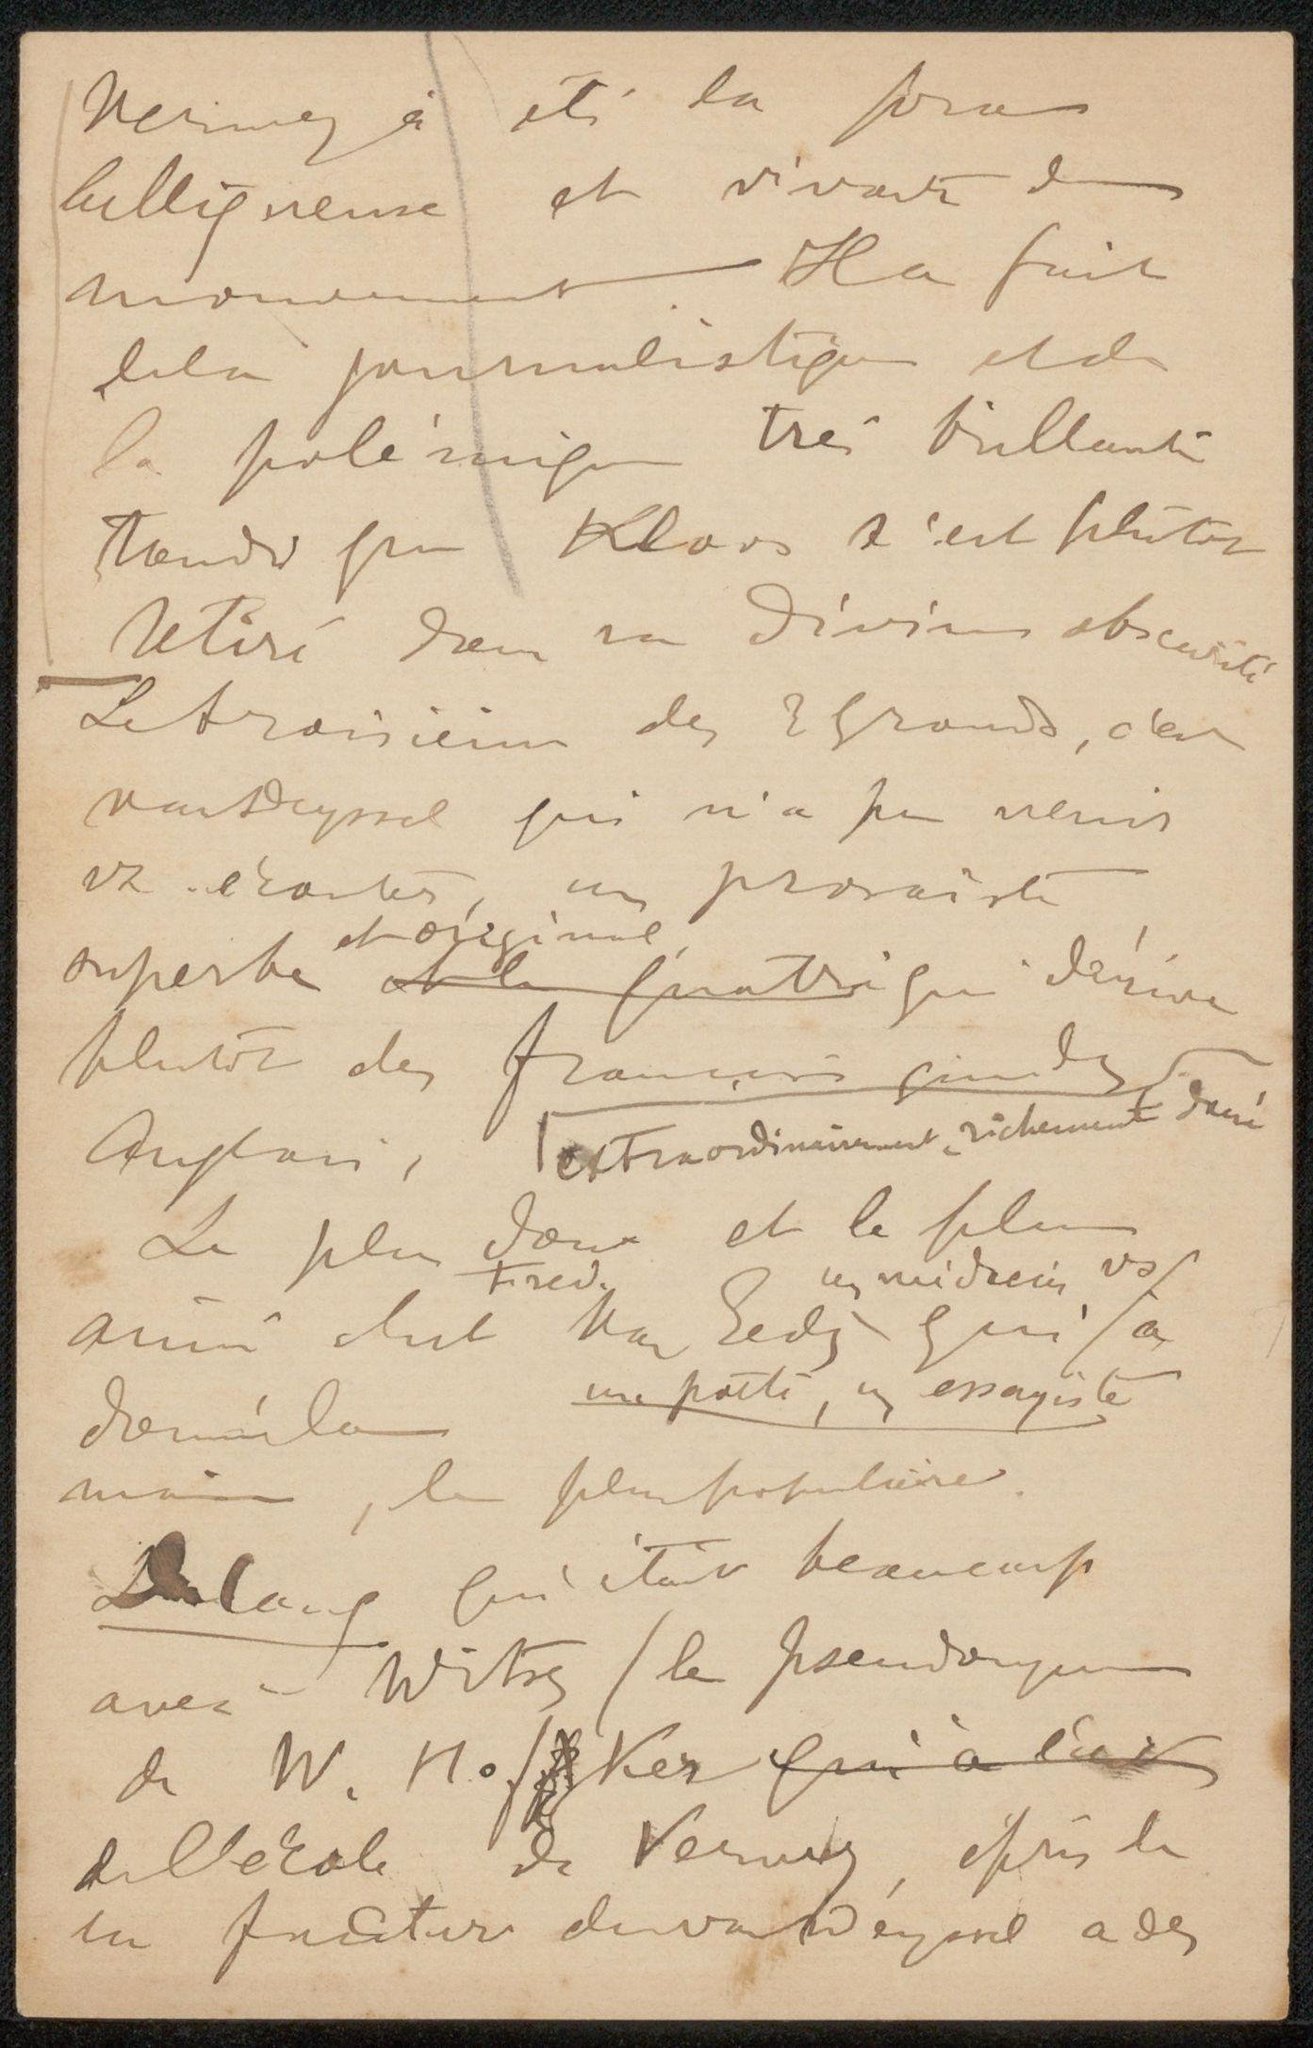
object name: aantekening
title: Aantekeningen uit archief Philip Zilcken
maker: philip zilcken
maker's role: draughtsman, painter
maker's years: 1857-1930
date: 1867-1930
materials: ink, paper, pencil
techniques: pen, printing, writing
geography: the hague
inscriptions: collector's mark: ‘RPK’